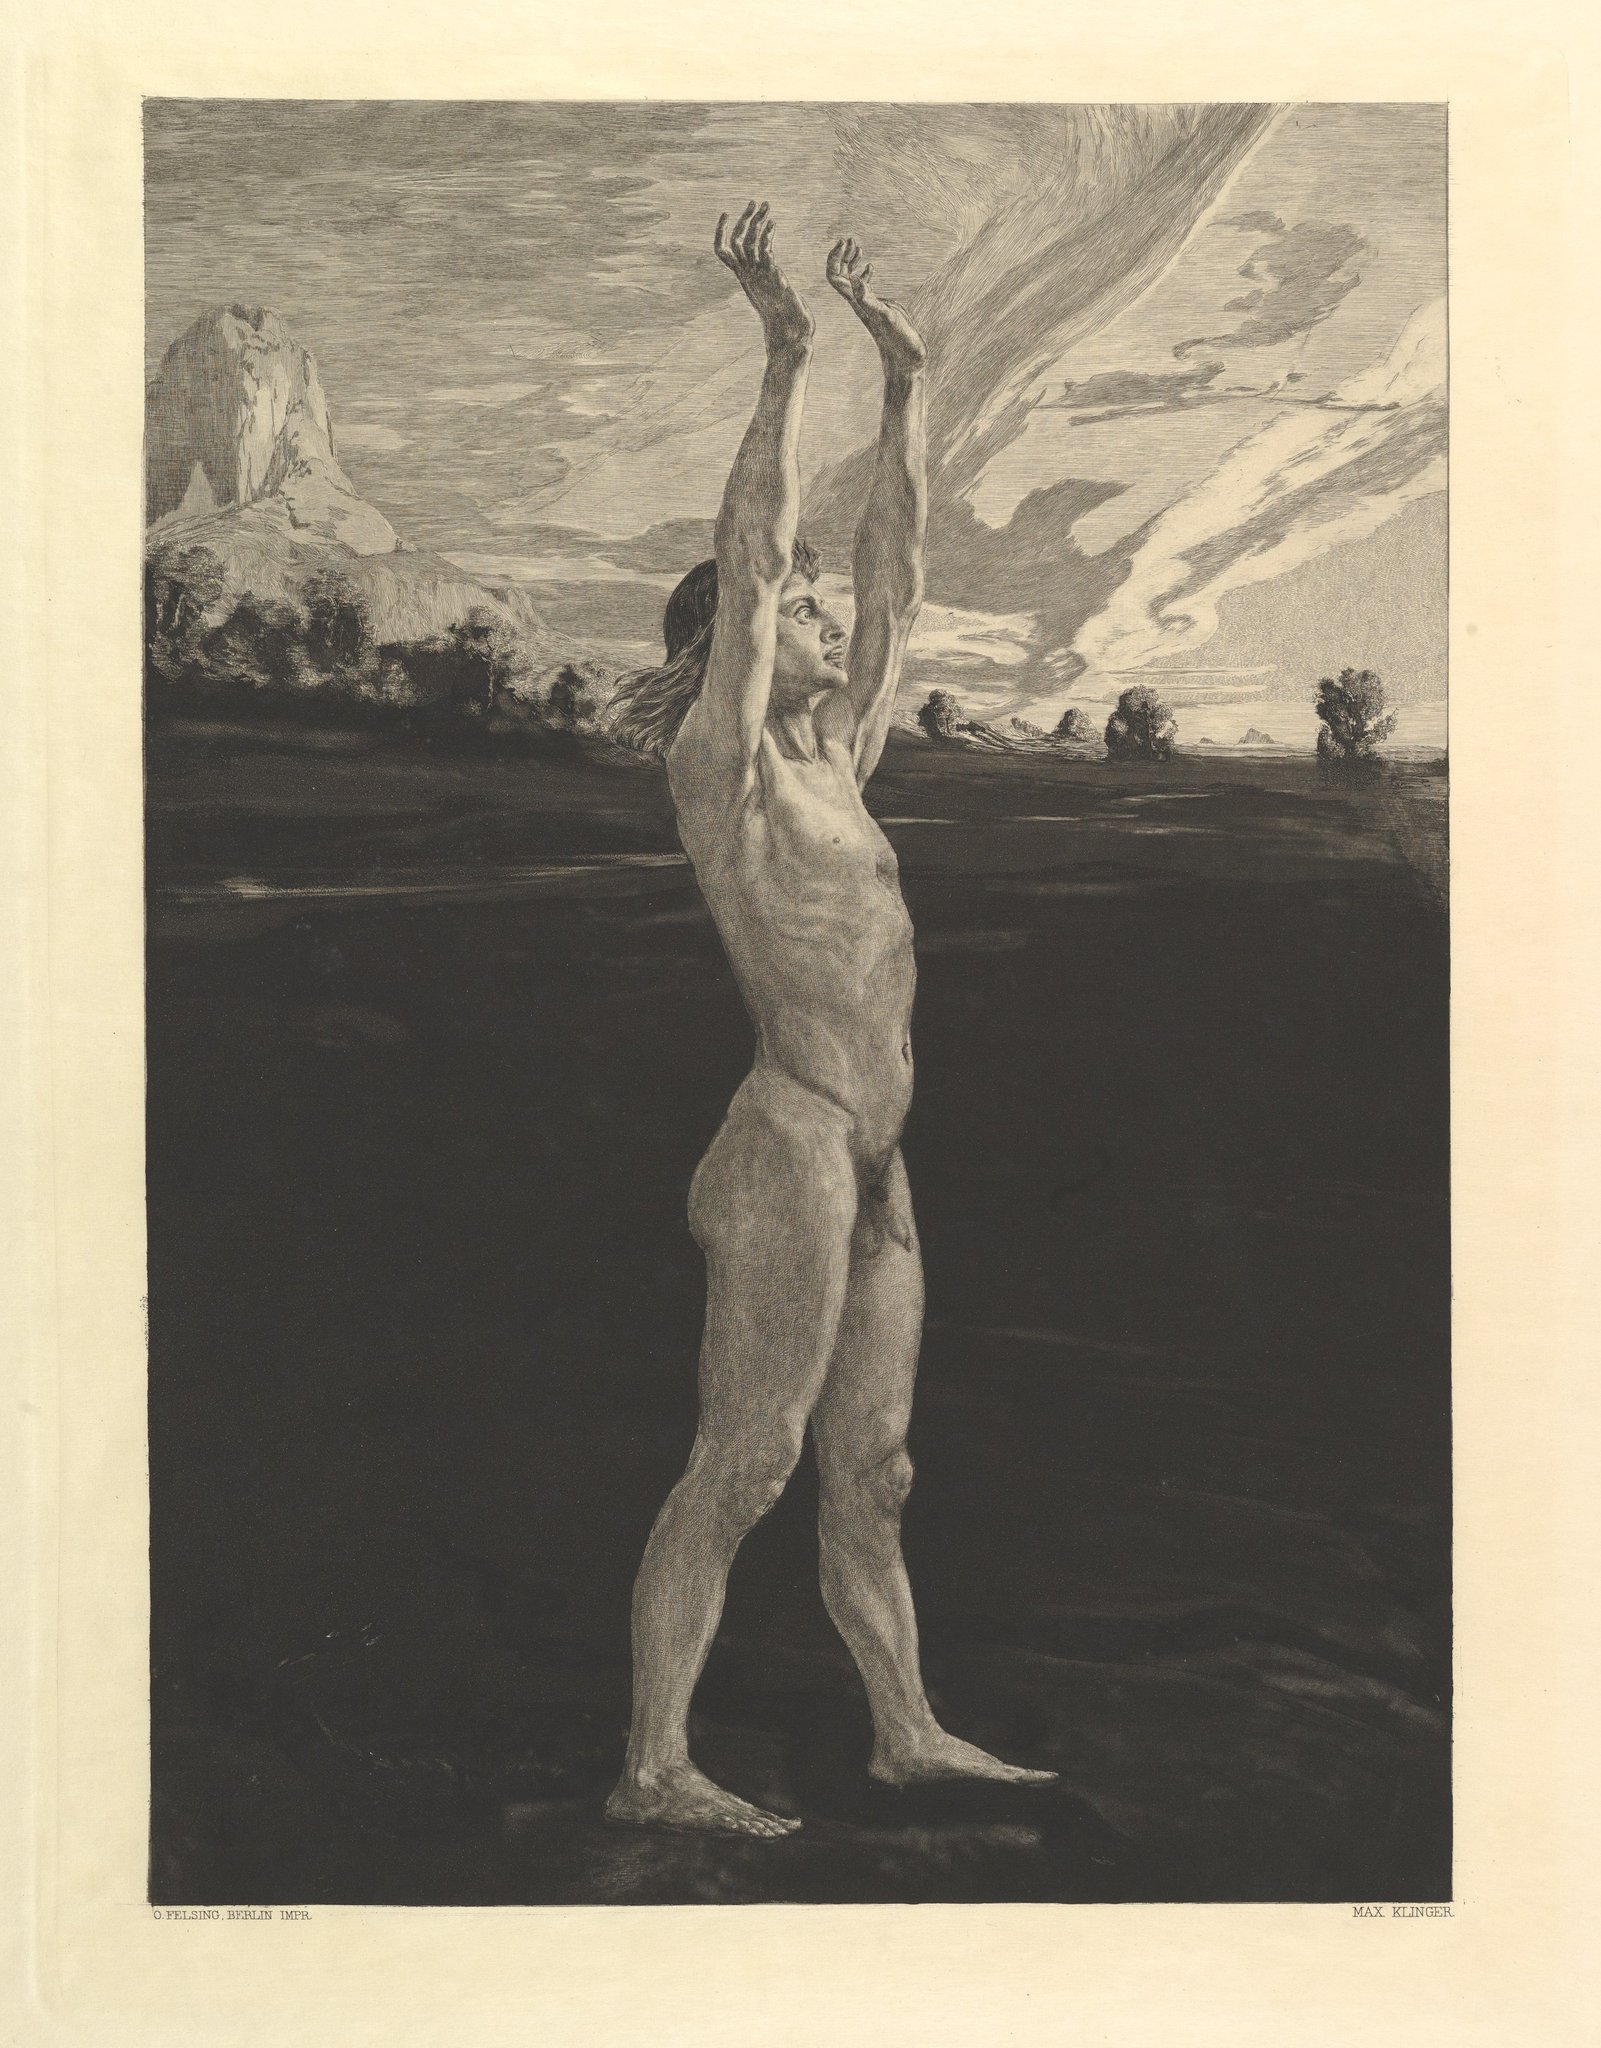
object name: print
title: Und Doch, from the series Vom Tode Zweiter Teil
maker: max klinger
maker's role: artist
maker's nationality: german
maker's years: 1857-1920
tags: male nudes